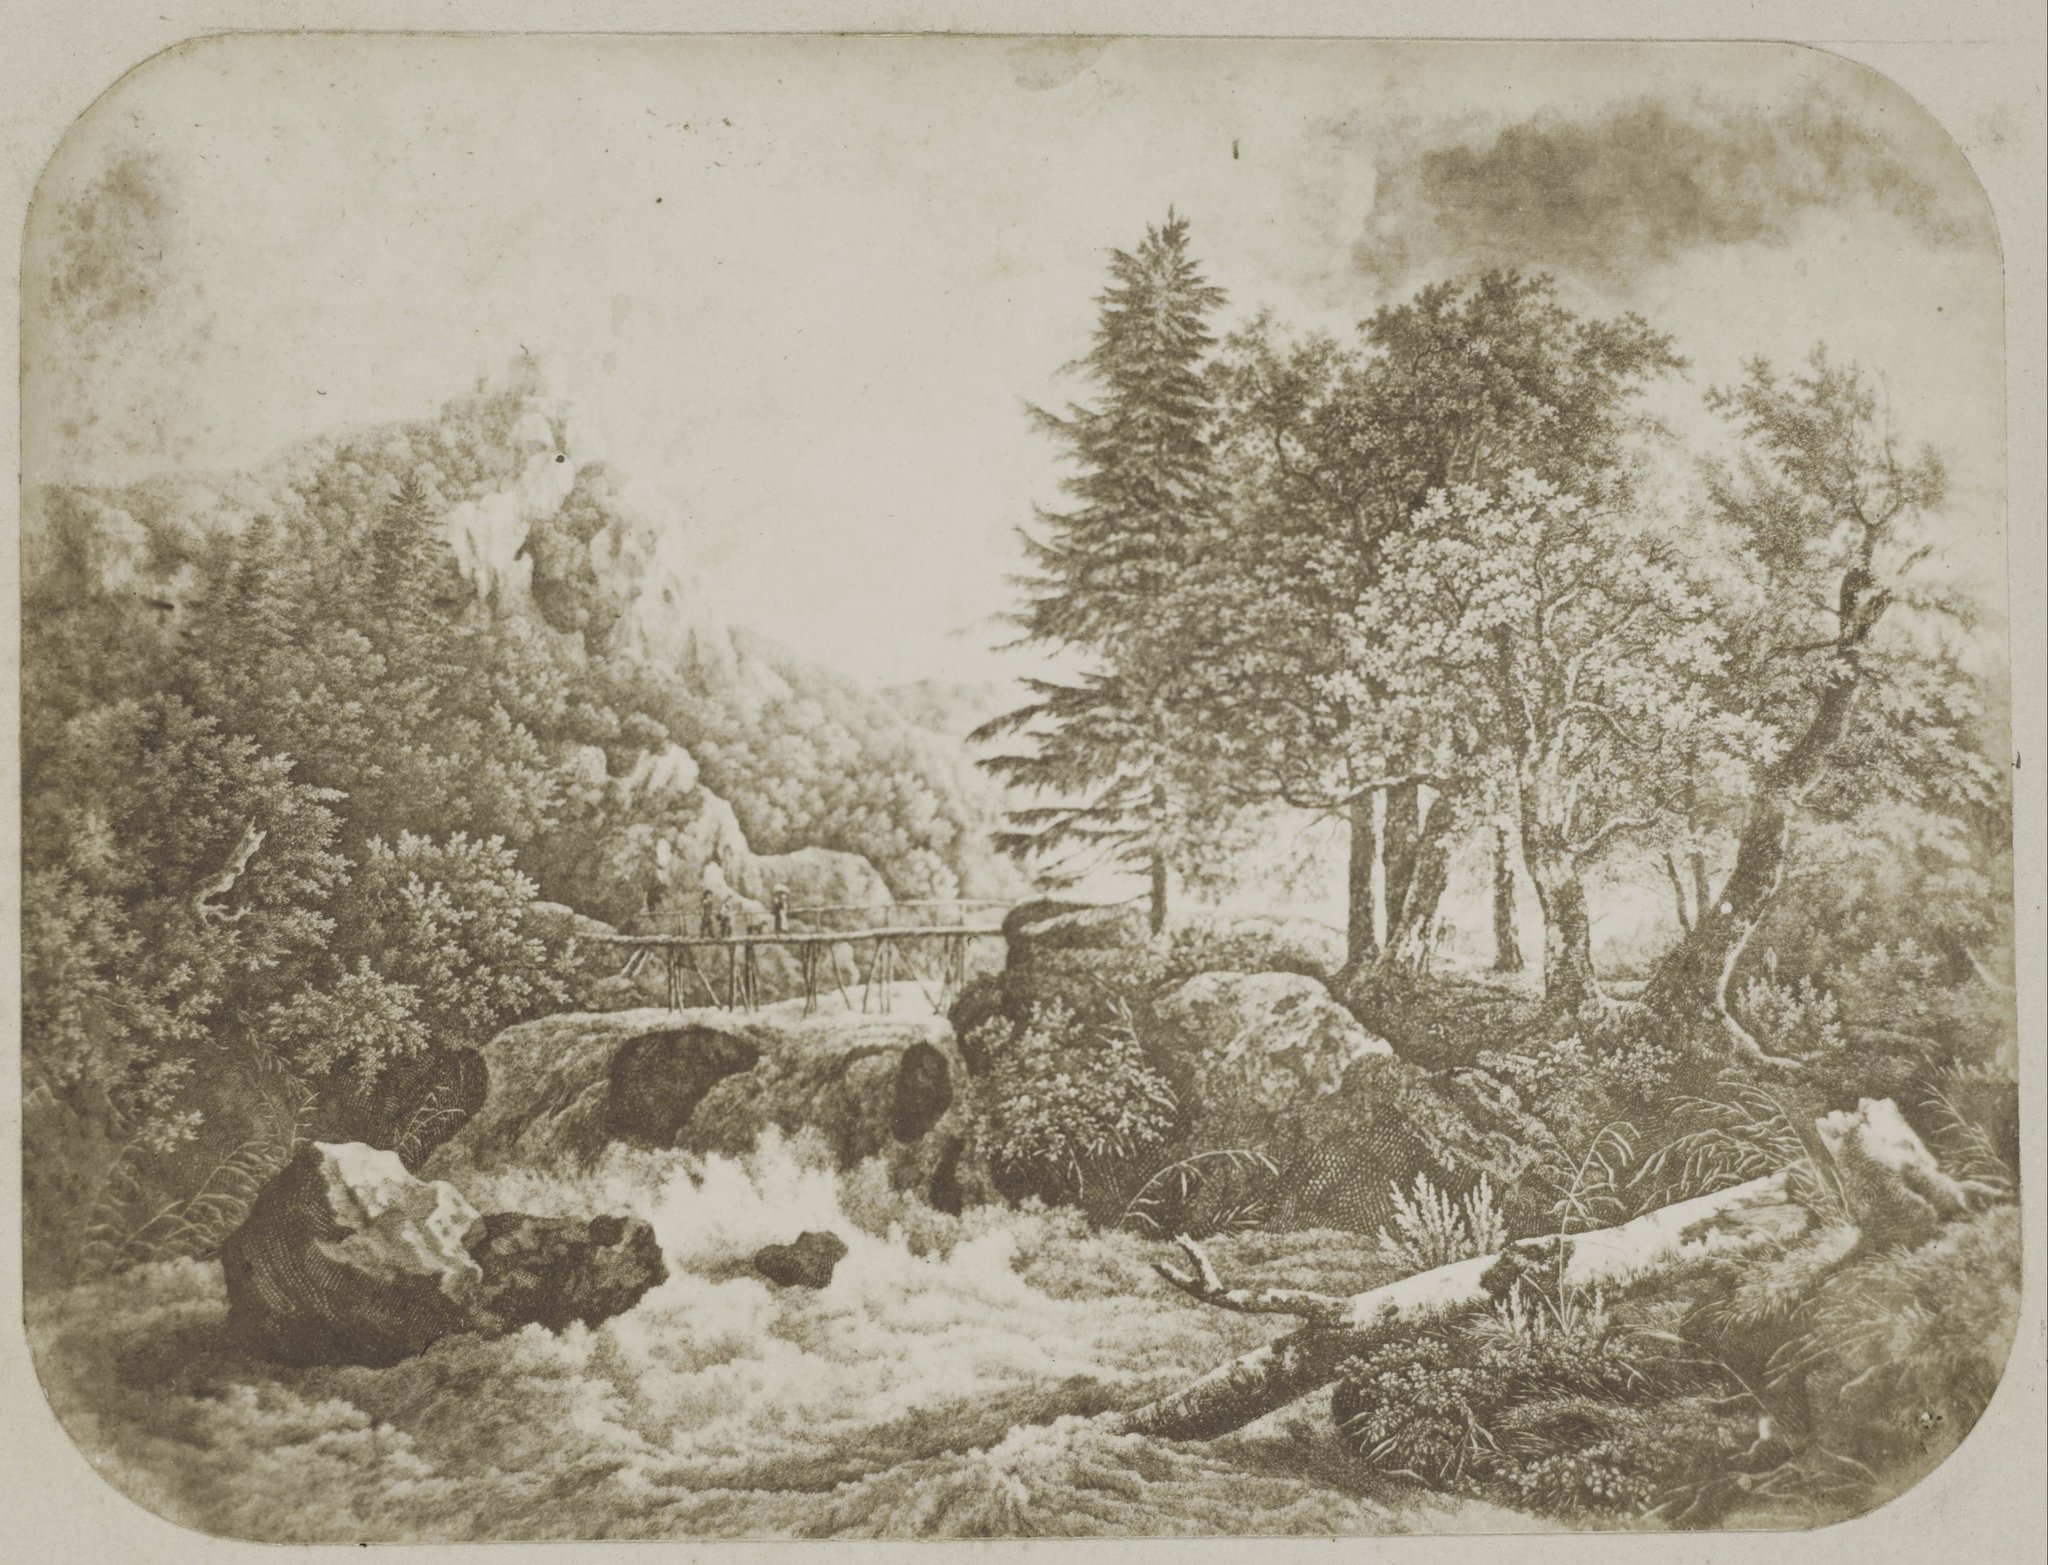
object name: photograph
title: Ets met een landschap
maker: eduard isaac asser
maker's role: amateurfotograaf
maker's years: 1809-1894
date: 1855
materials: cardboard, paper, photographic support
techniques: salted paper print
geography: amsterdam